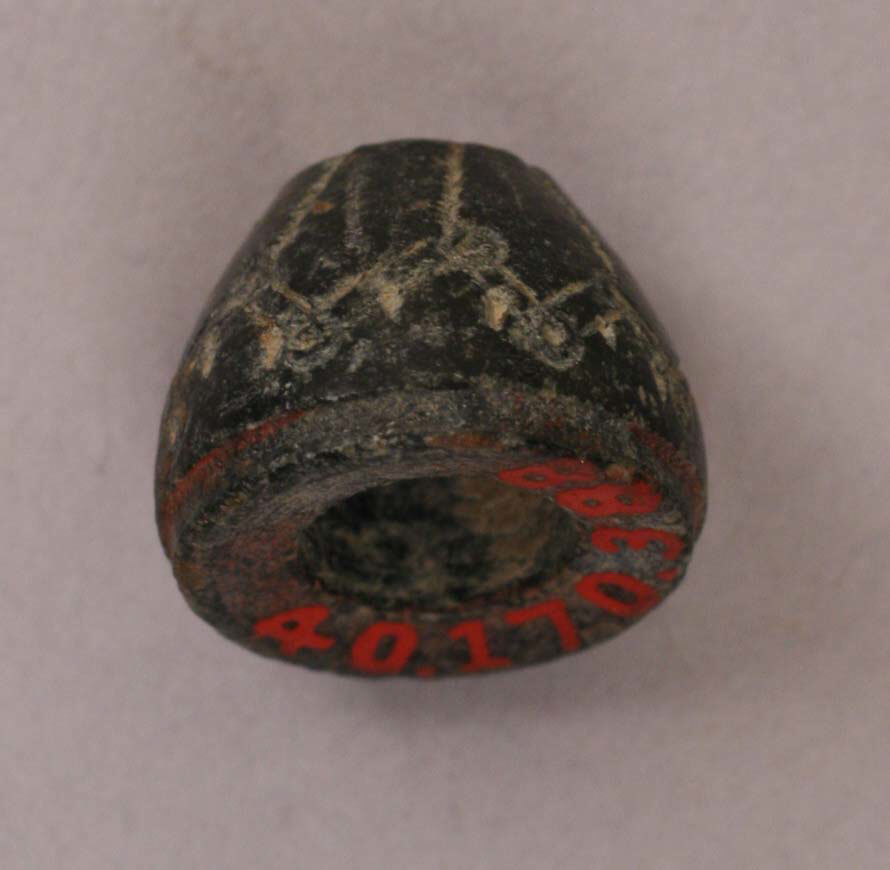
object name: button or bead or spindle whorl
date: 701-1000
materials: stone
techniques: incising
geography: iran